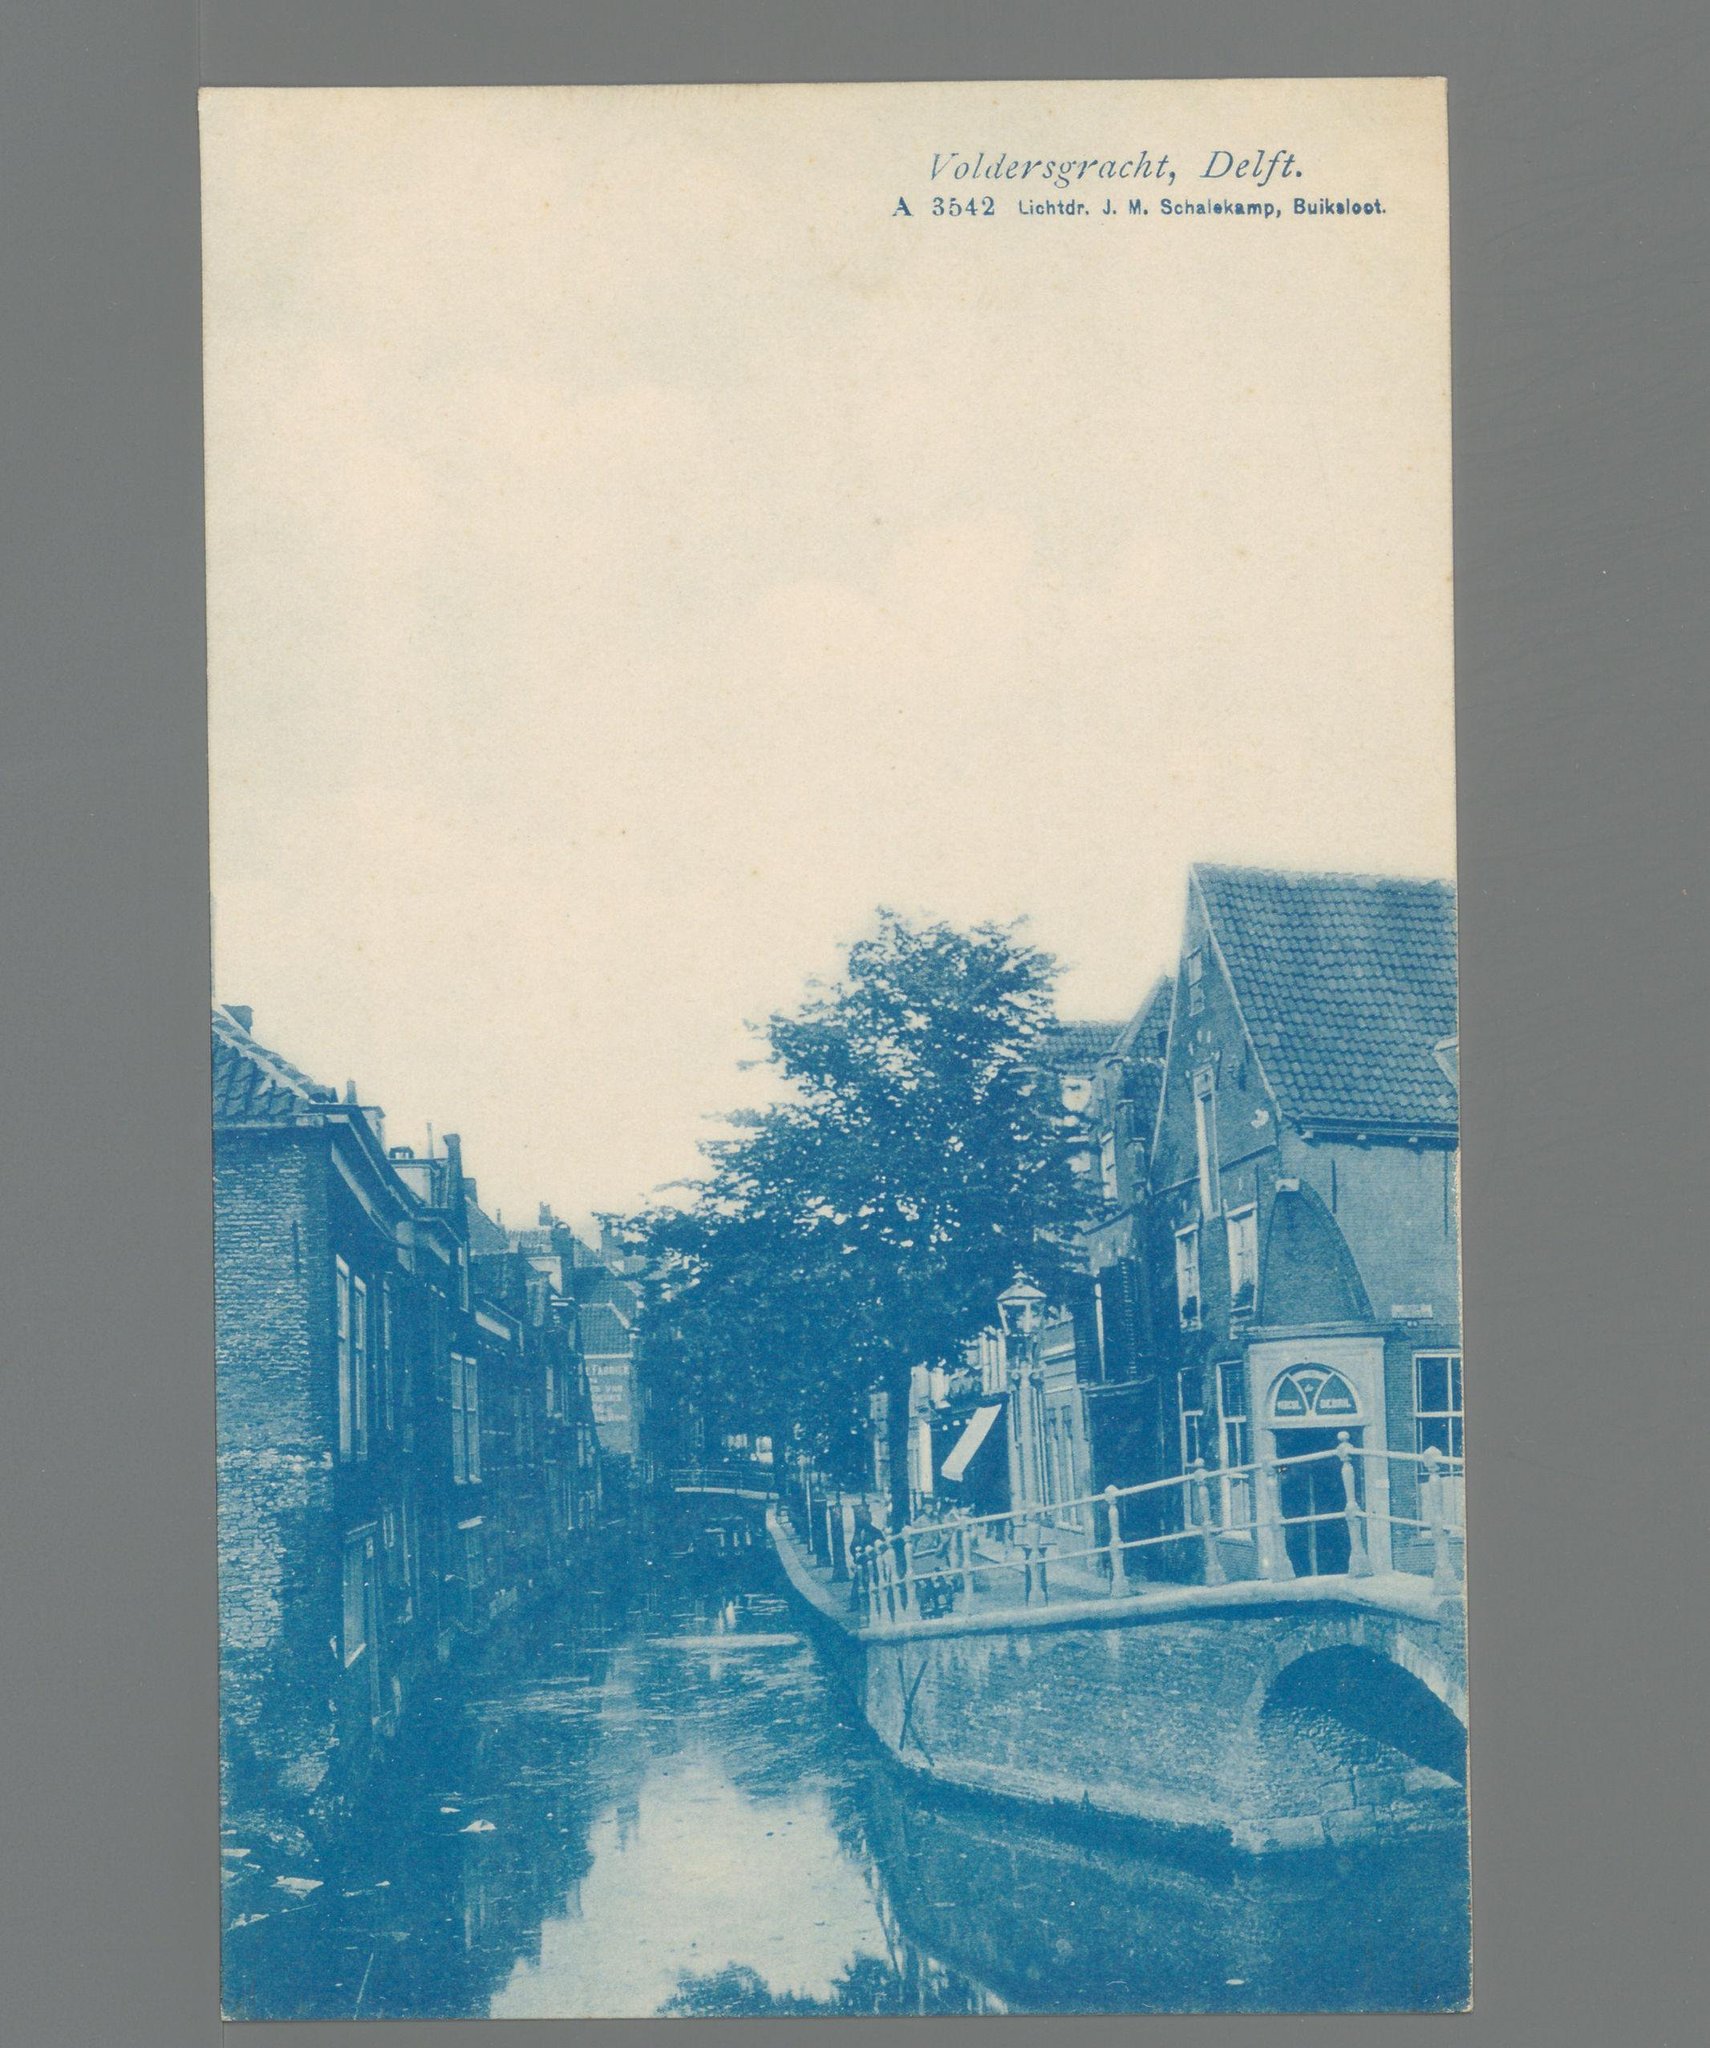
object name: ansichtkaart, prentbriefkaart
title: Voldersgracht, Delft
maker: johan marinus schalekamp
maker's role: publisher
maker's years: 1844-1912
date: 1905-1926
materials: cardboard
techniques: photograph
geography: buiksloot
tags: canals, waters (in city), bridge in city across river, canal, etc., street